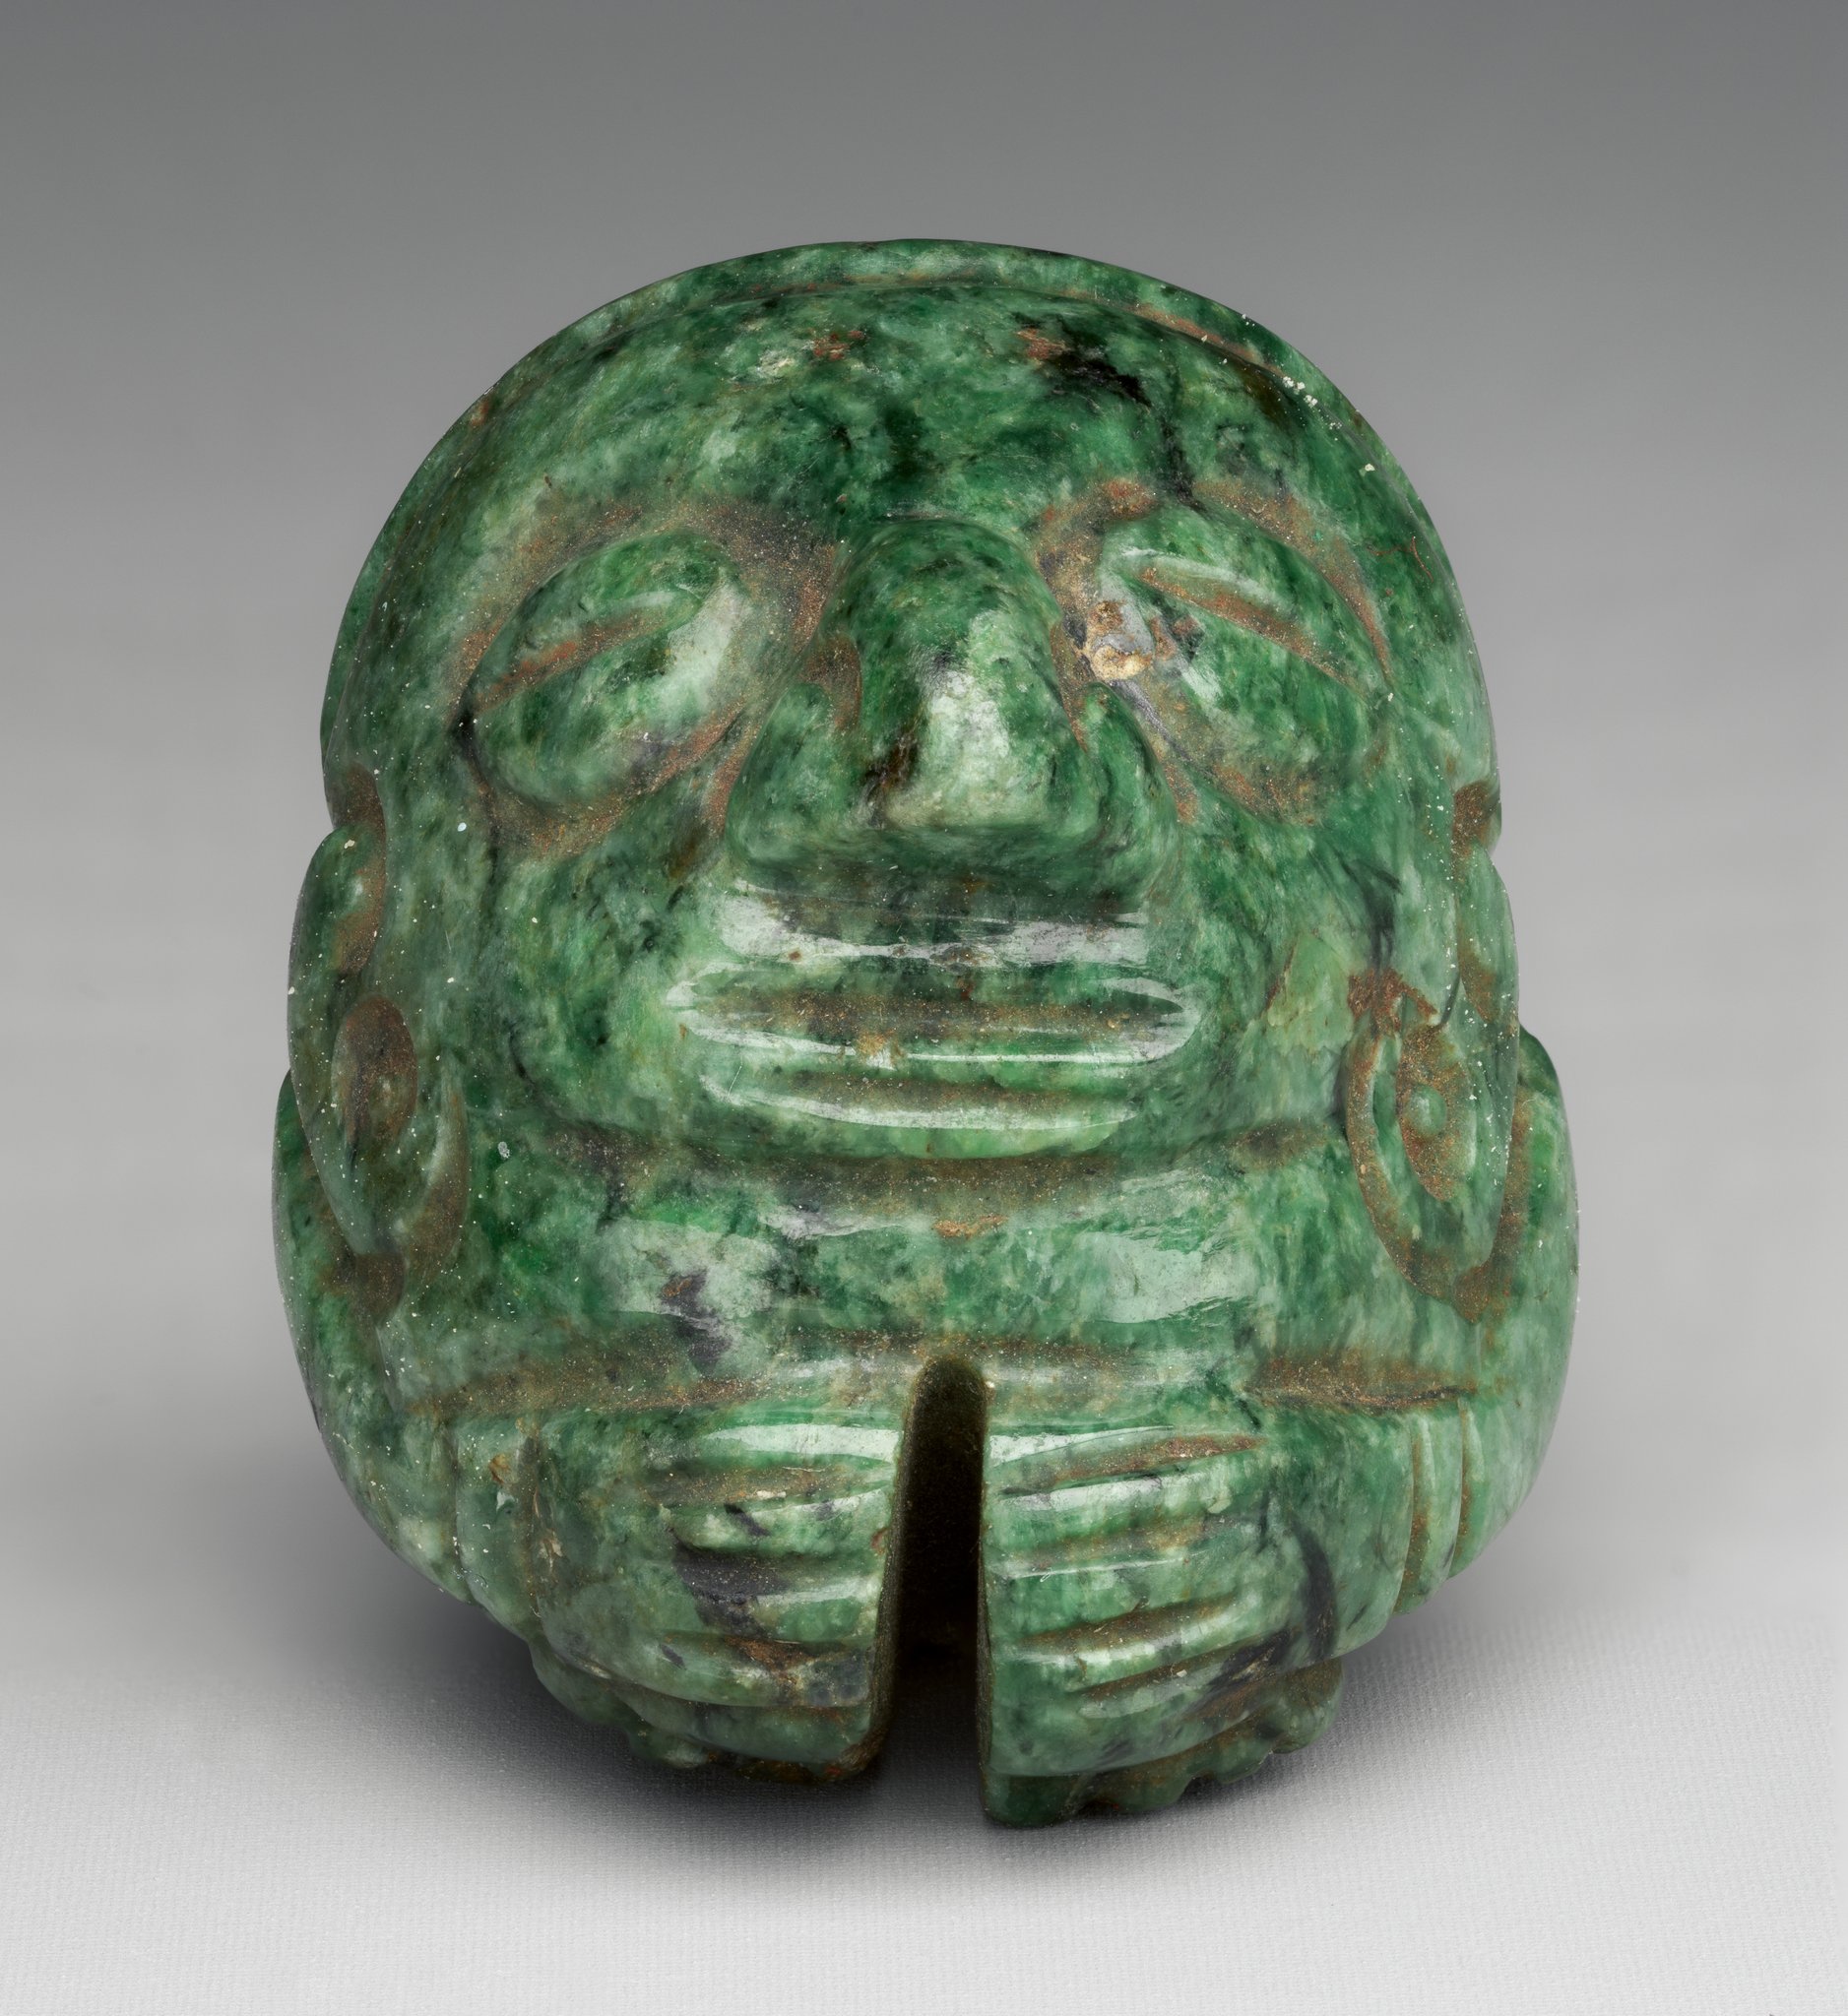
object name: bead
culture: mixtec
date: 901-1300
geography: mexico